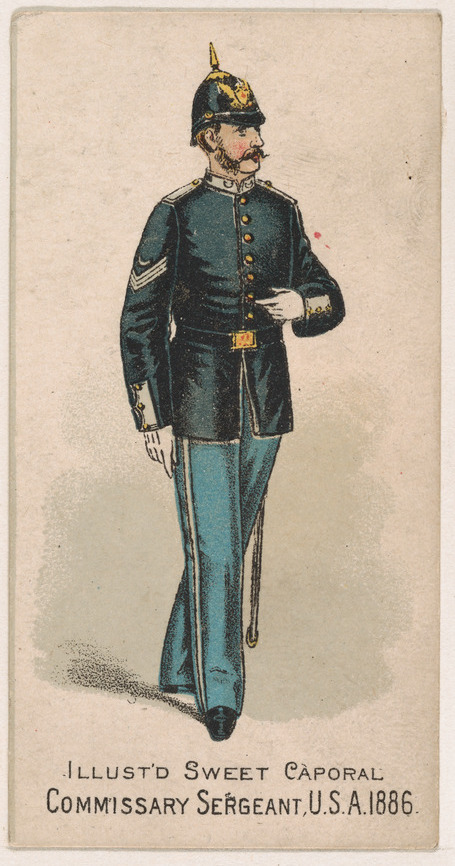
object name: print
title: Commissary Sergeant, United States Army, 1886, from the Military Series (N224) issued by Kinney Tobacco Company to promote Sweet Caporal Cigarettes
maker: kinney brothers tobacco company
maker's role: publisher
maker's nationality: american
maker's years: 1869-2011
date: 1888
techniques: color lithograph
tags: military,men,profiles